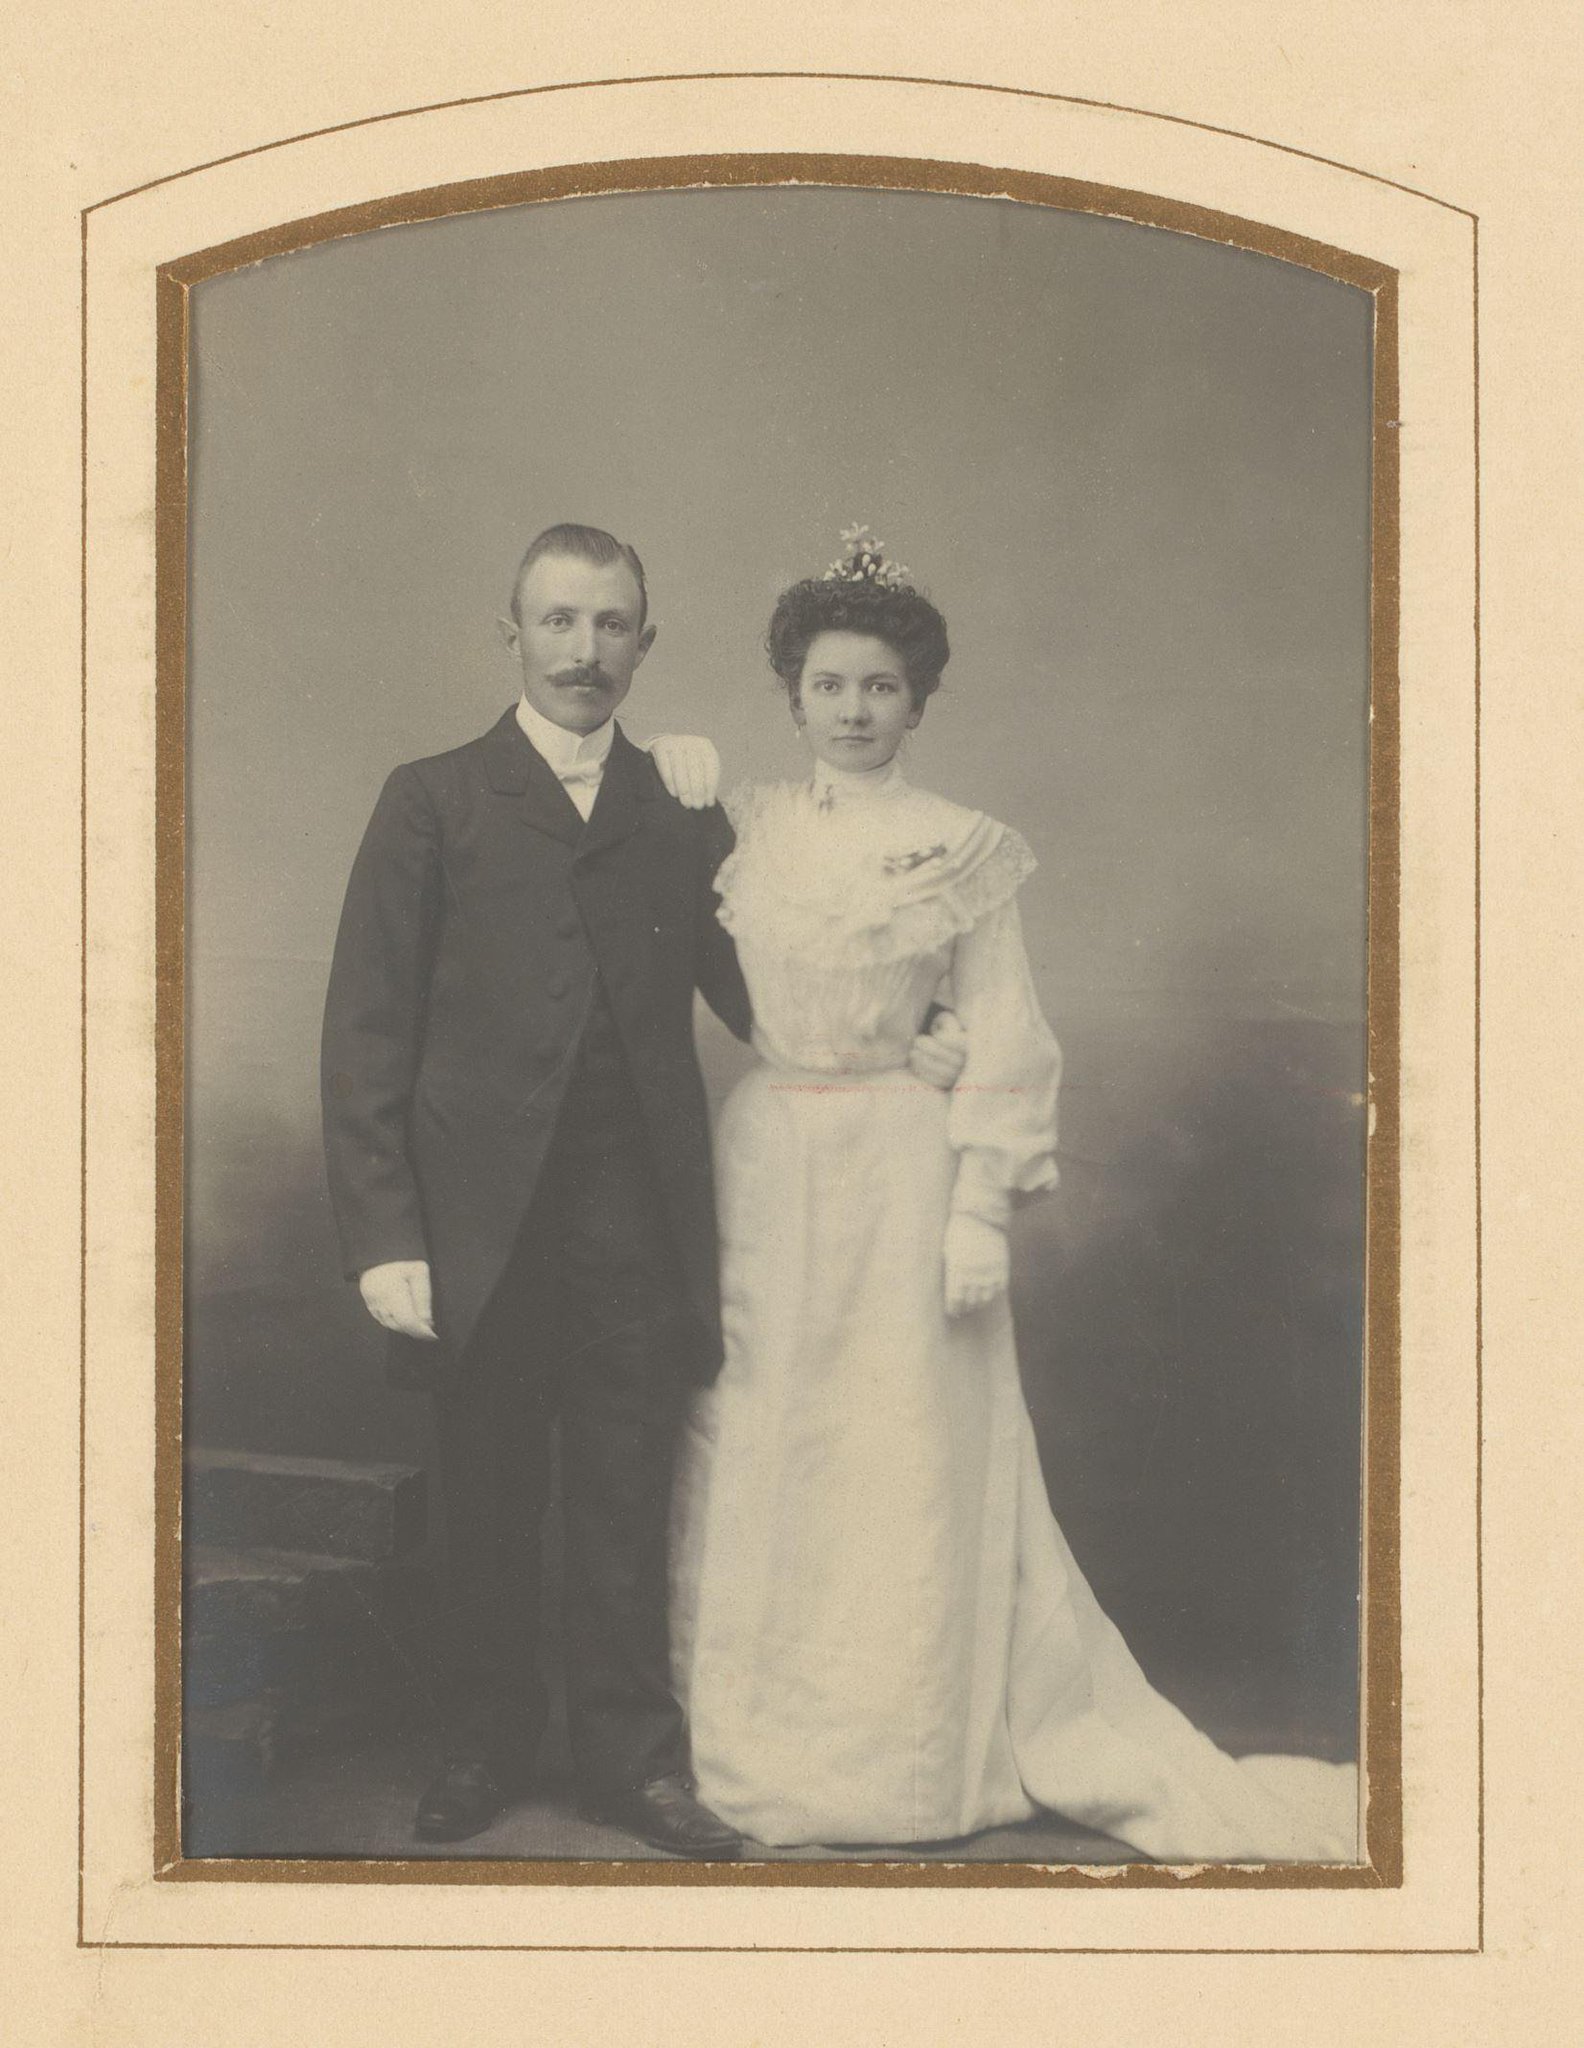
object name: cabinet photograph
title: Portret van een echtpaar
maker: Anonymous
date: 1900-1940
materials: cardboard, photographic support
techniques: gelatin silver print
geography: paris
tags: bride and groom in wedding-dress